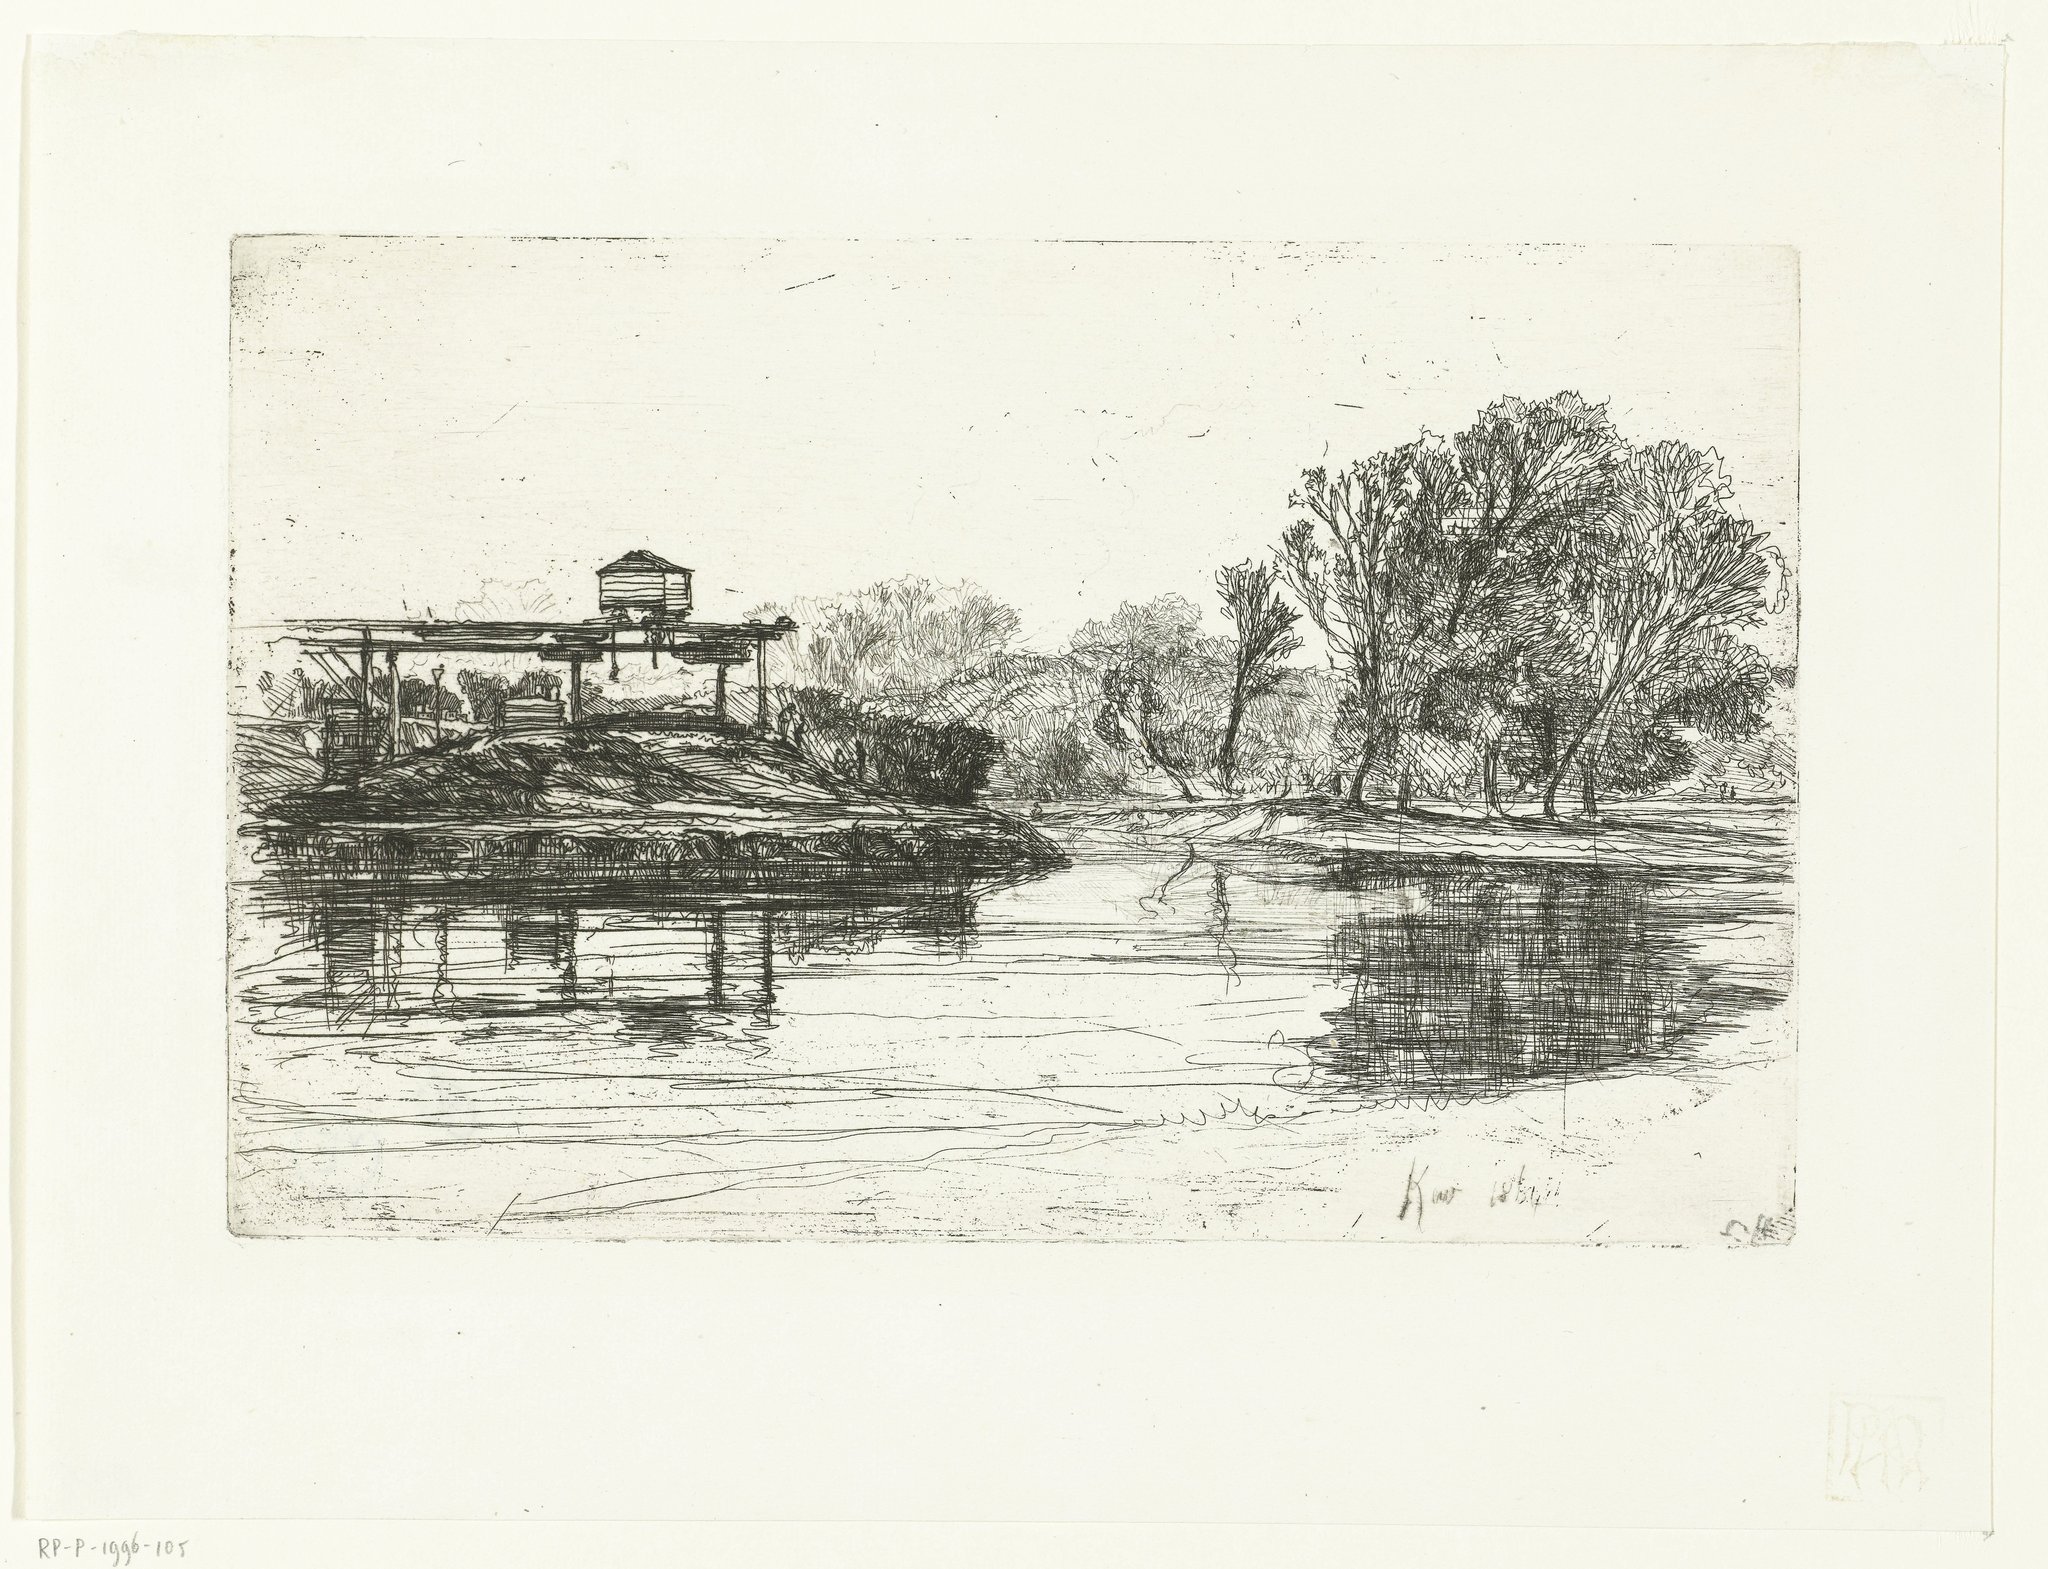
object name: print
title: Spoorweg uitbreiding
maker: francis seymour-haden (sir)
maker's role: print maker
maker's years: 1818-1910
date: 1864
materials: paper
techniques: drypoint, etching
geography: england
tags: landscape with bridge, viaduct or aqueduct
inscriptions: collector's mark: ‘v E’, collector's mark: ‘D’, collector's mark: Lugt 2760, collector's mark: Lugt 2228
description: Een bocht in de rivier de Theems met op de rechteroever bomen en links een houten stelling.